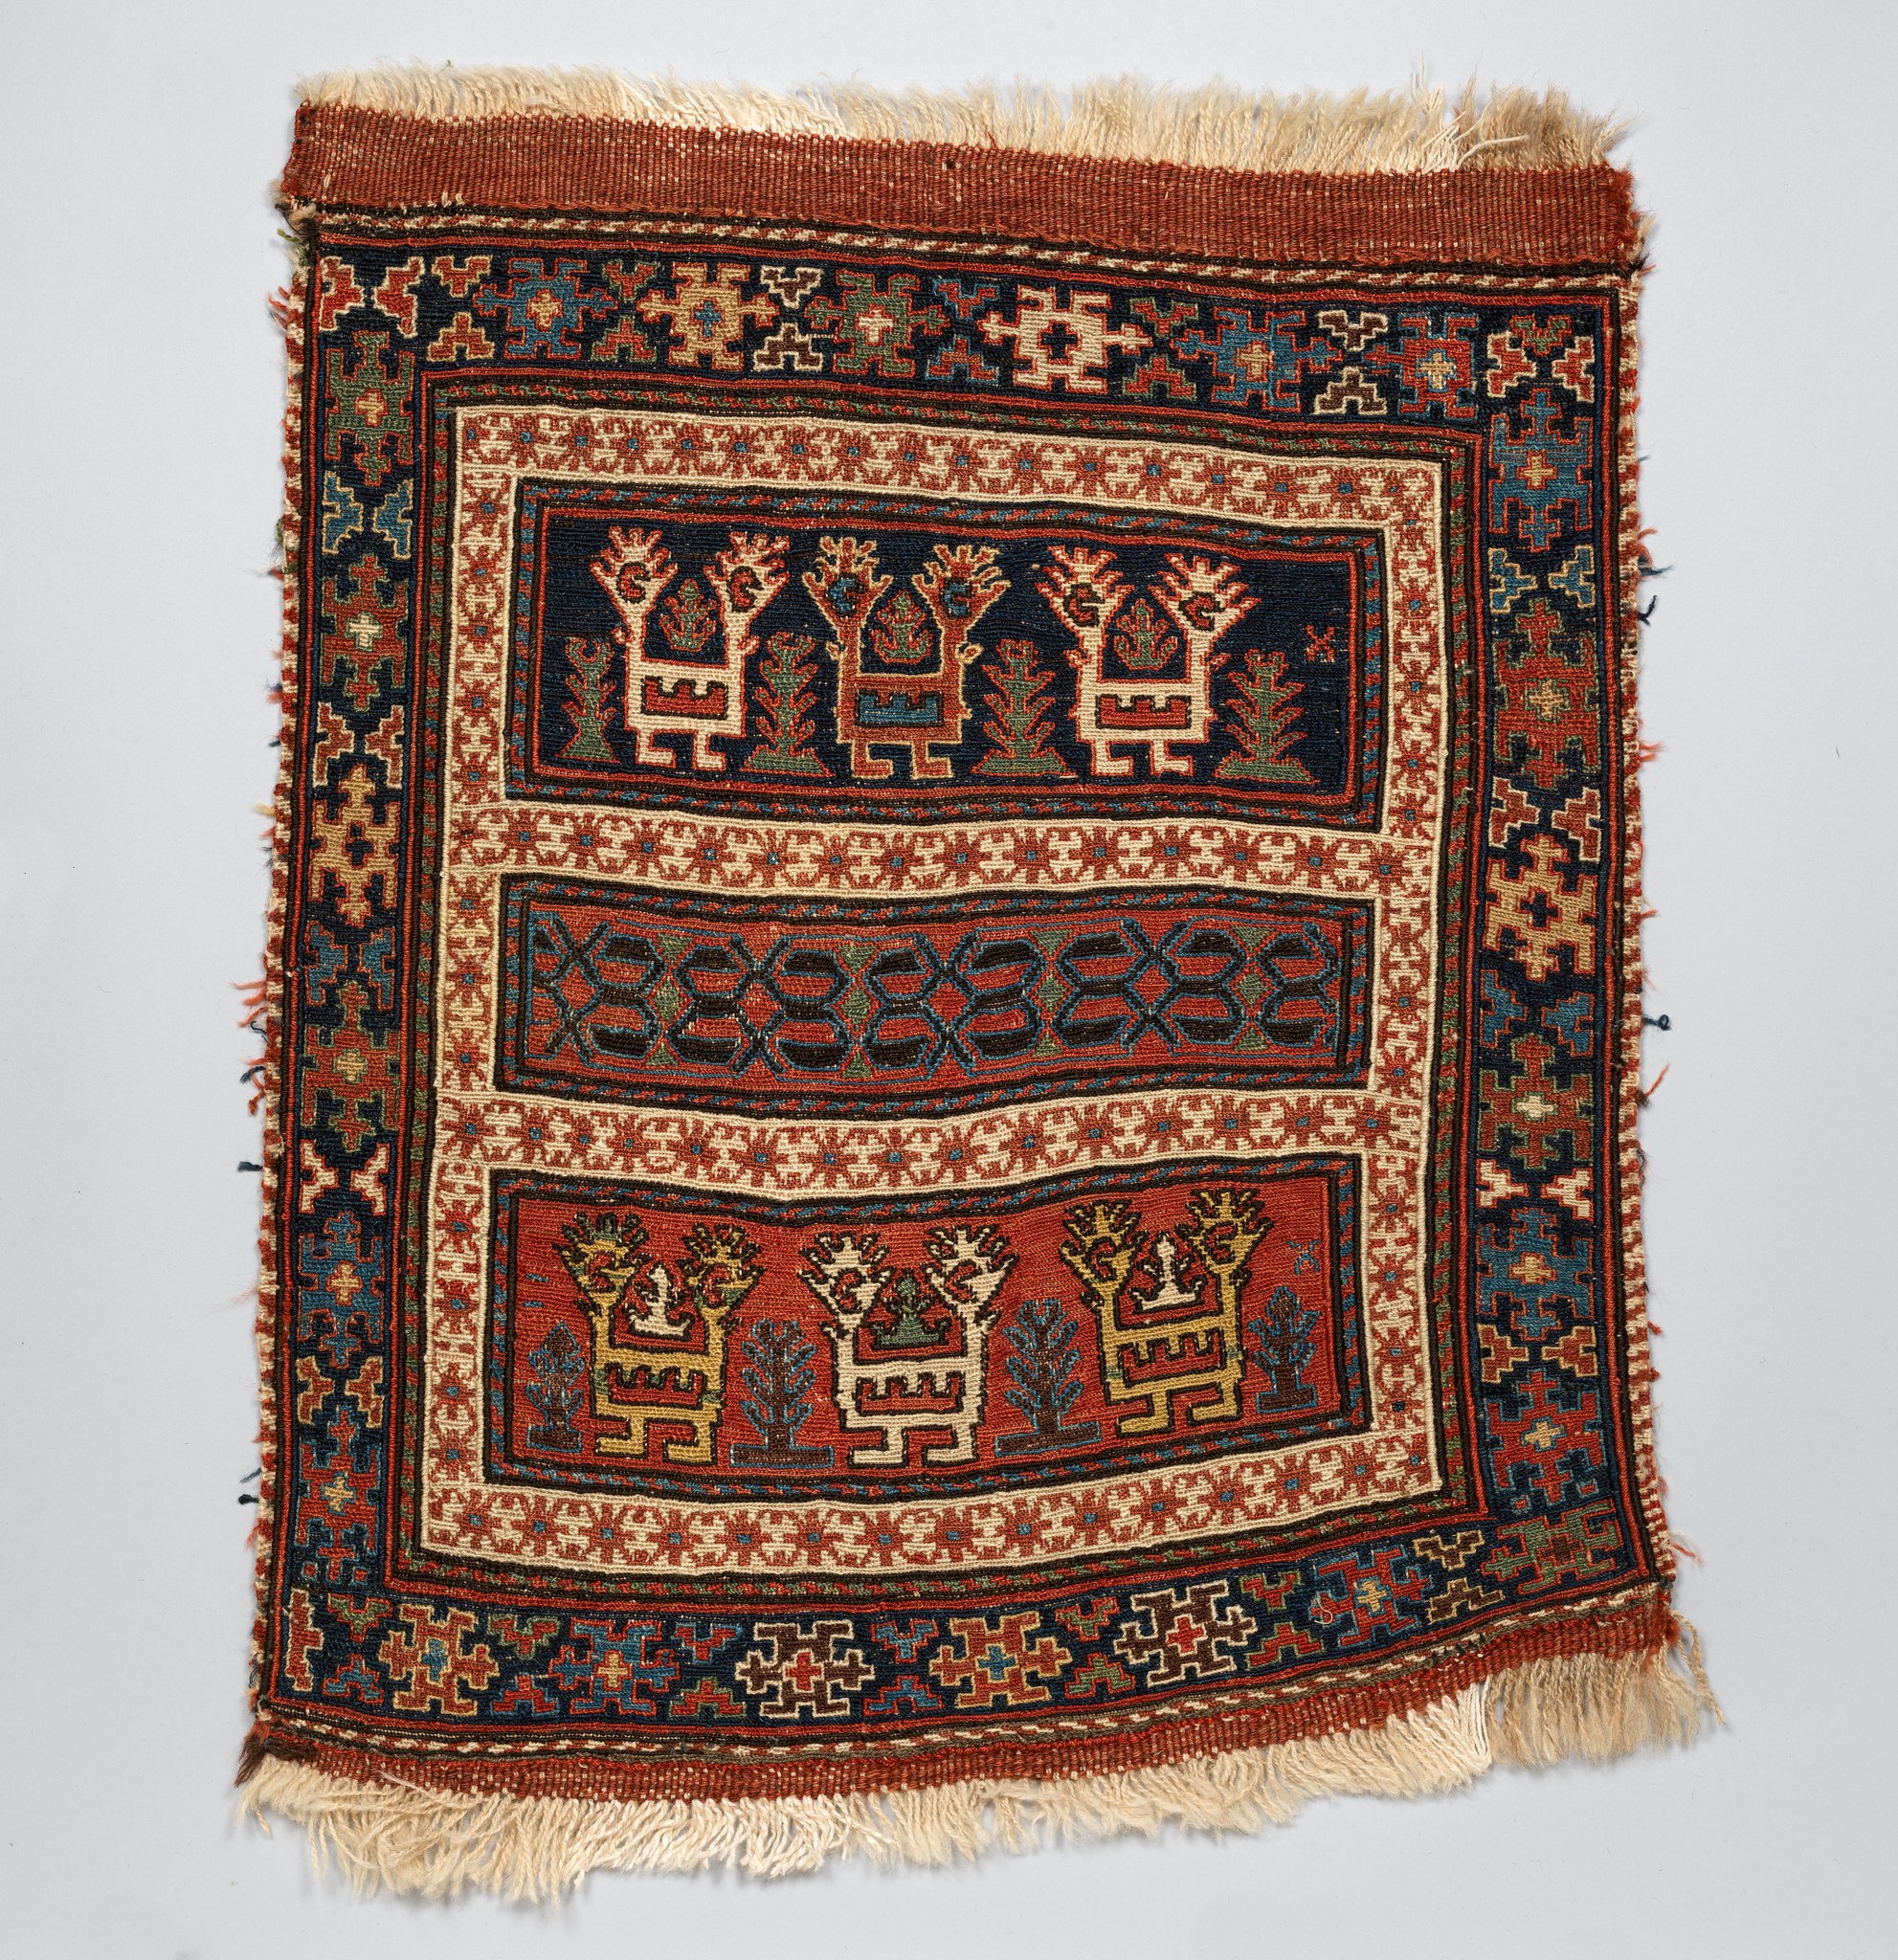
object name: bag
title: Bag Face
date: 1801-1900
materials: wool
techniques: brocade, weave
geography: northwestern iran